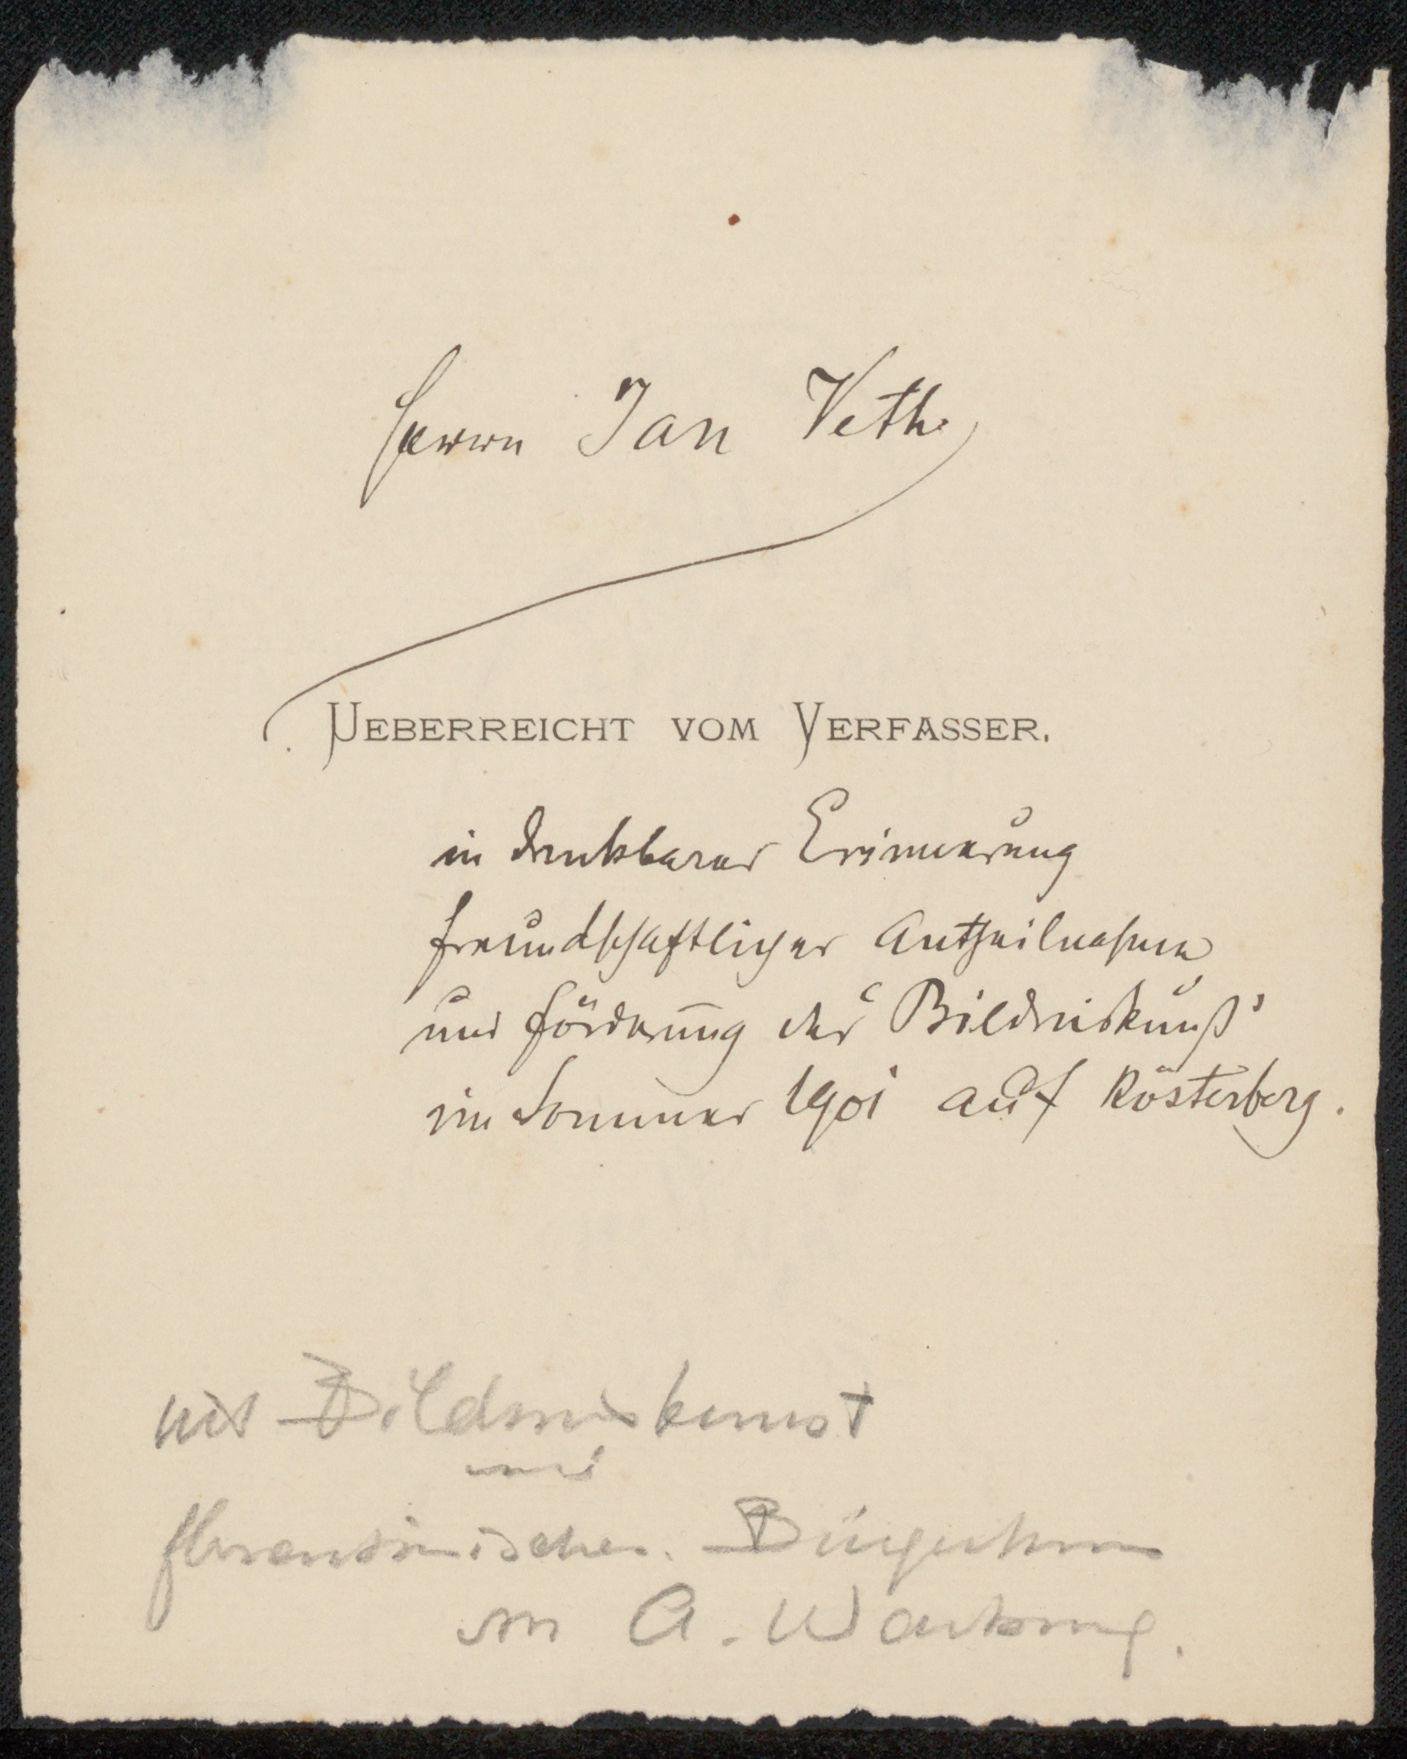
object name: letter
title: Brief aan Jan Veth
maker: aby warburg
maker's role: amateurfotograaf, kunsthistoricus, kunsttheoreticus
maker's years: 1866-1929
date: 1901-1927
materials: ink, paper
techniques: pen, printing, writing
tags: dordrecht, amsterdam, painter, draughtsman, designer, jan veth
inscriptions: watermark, collector's mark: ‘RPK’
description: Brief bevat de huwelijksaankondiging van Aby Warburgs dochter Marietta.